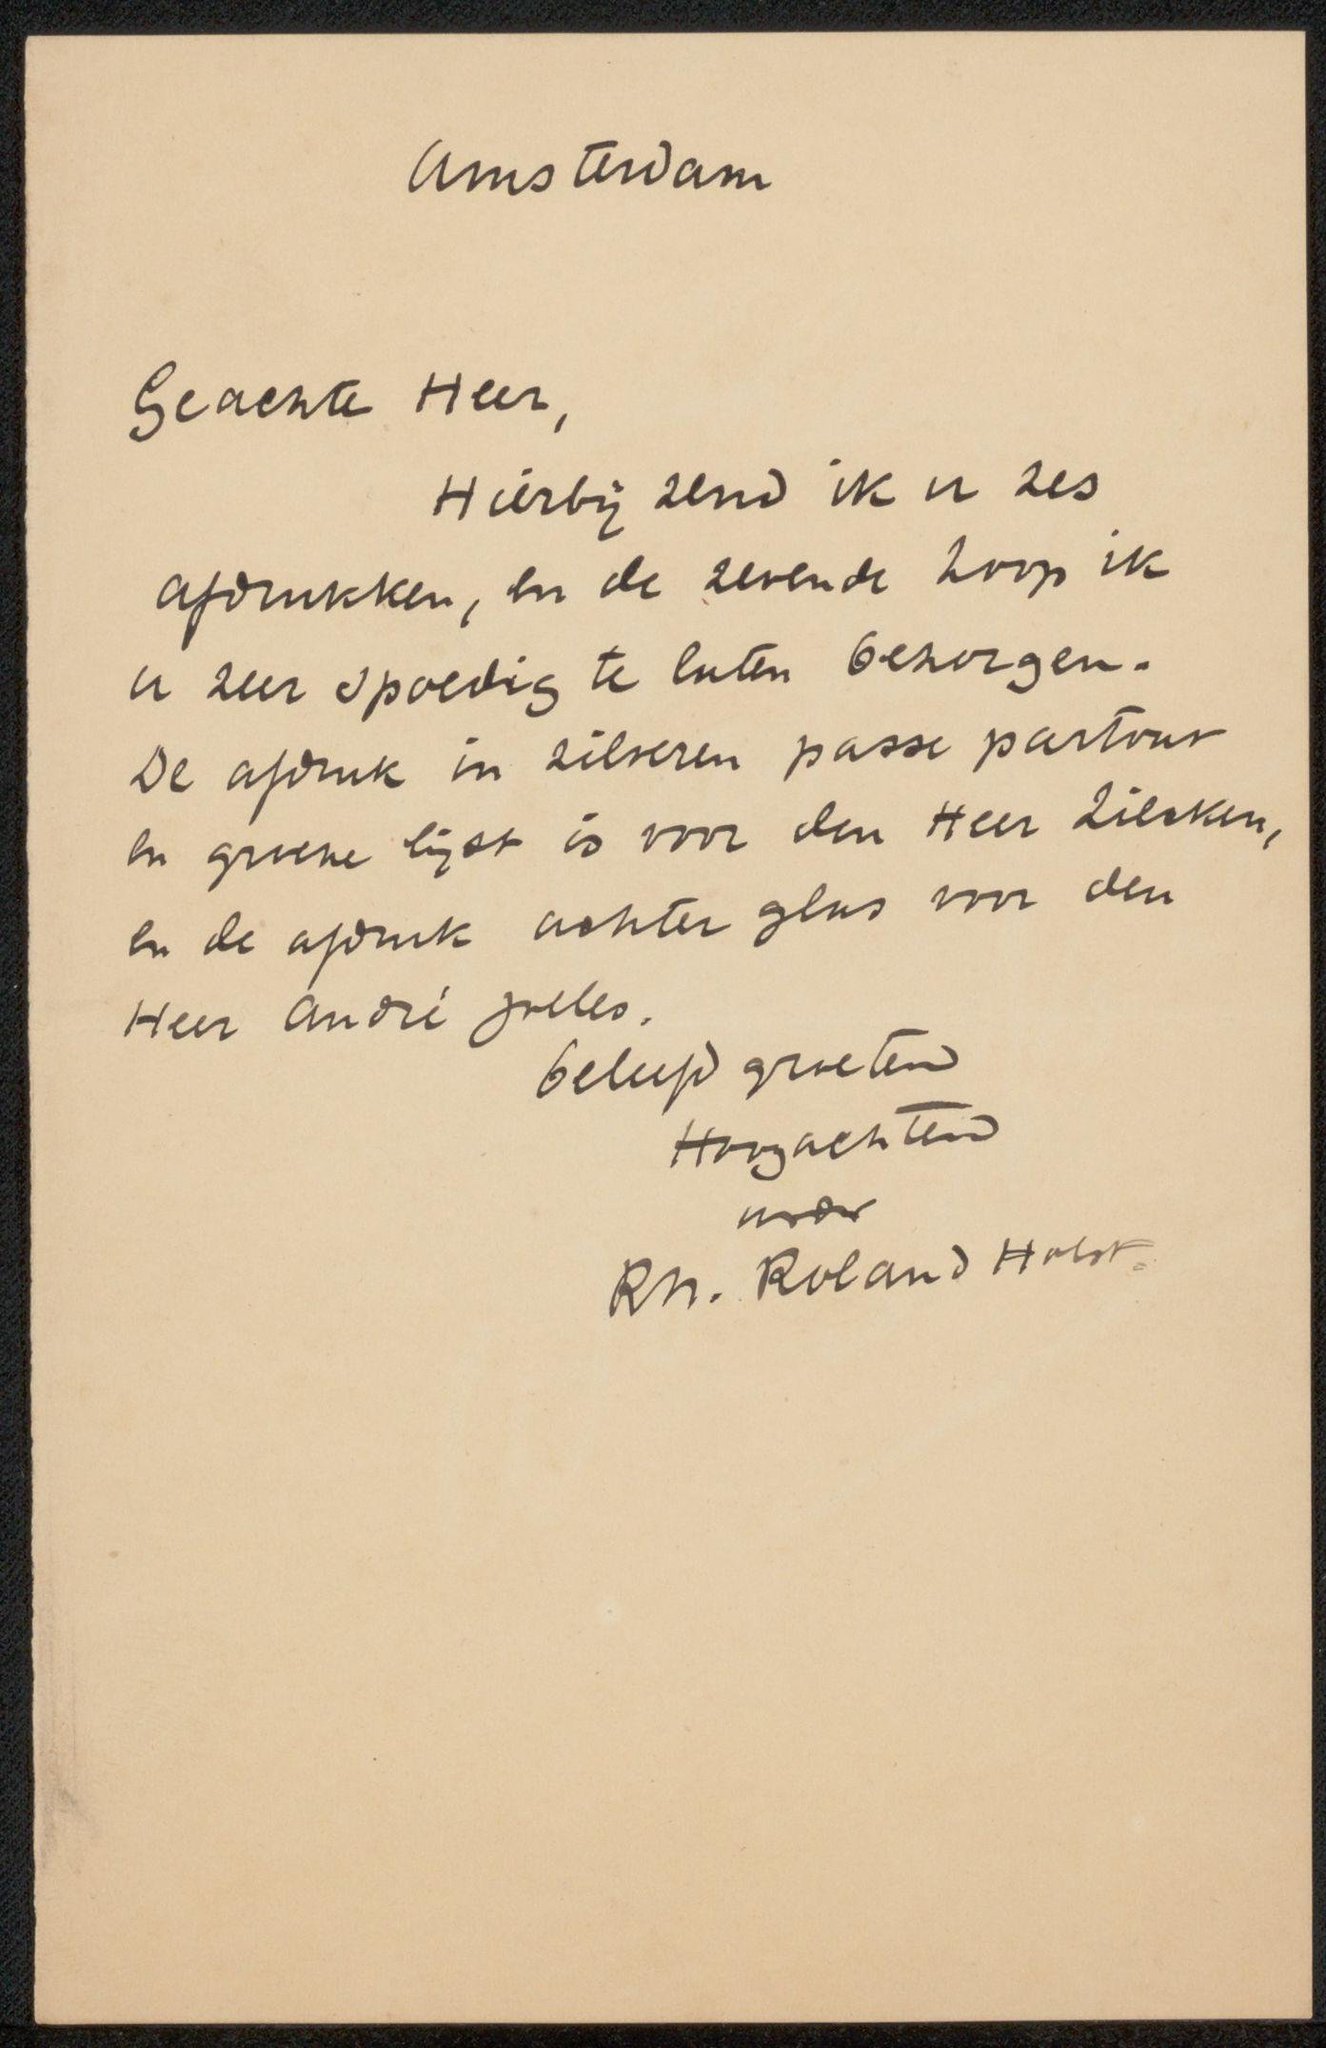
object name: letter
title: Brief aan anoniem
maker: richard nicolaüs roland holst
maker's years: 1868-1938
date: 1878-1930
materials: ink, paper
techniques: pen, writing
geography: amsterdam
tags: andré jolles, painter, draughtsman, philip zilcken, the graphic arts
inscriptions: watermark, collector's mark: ‘RPK’